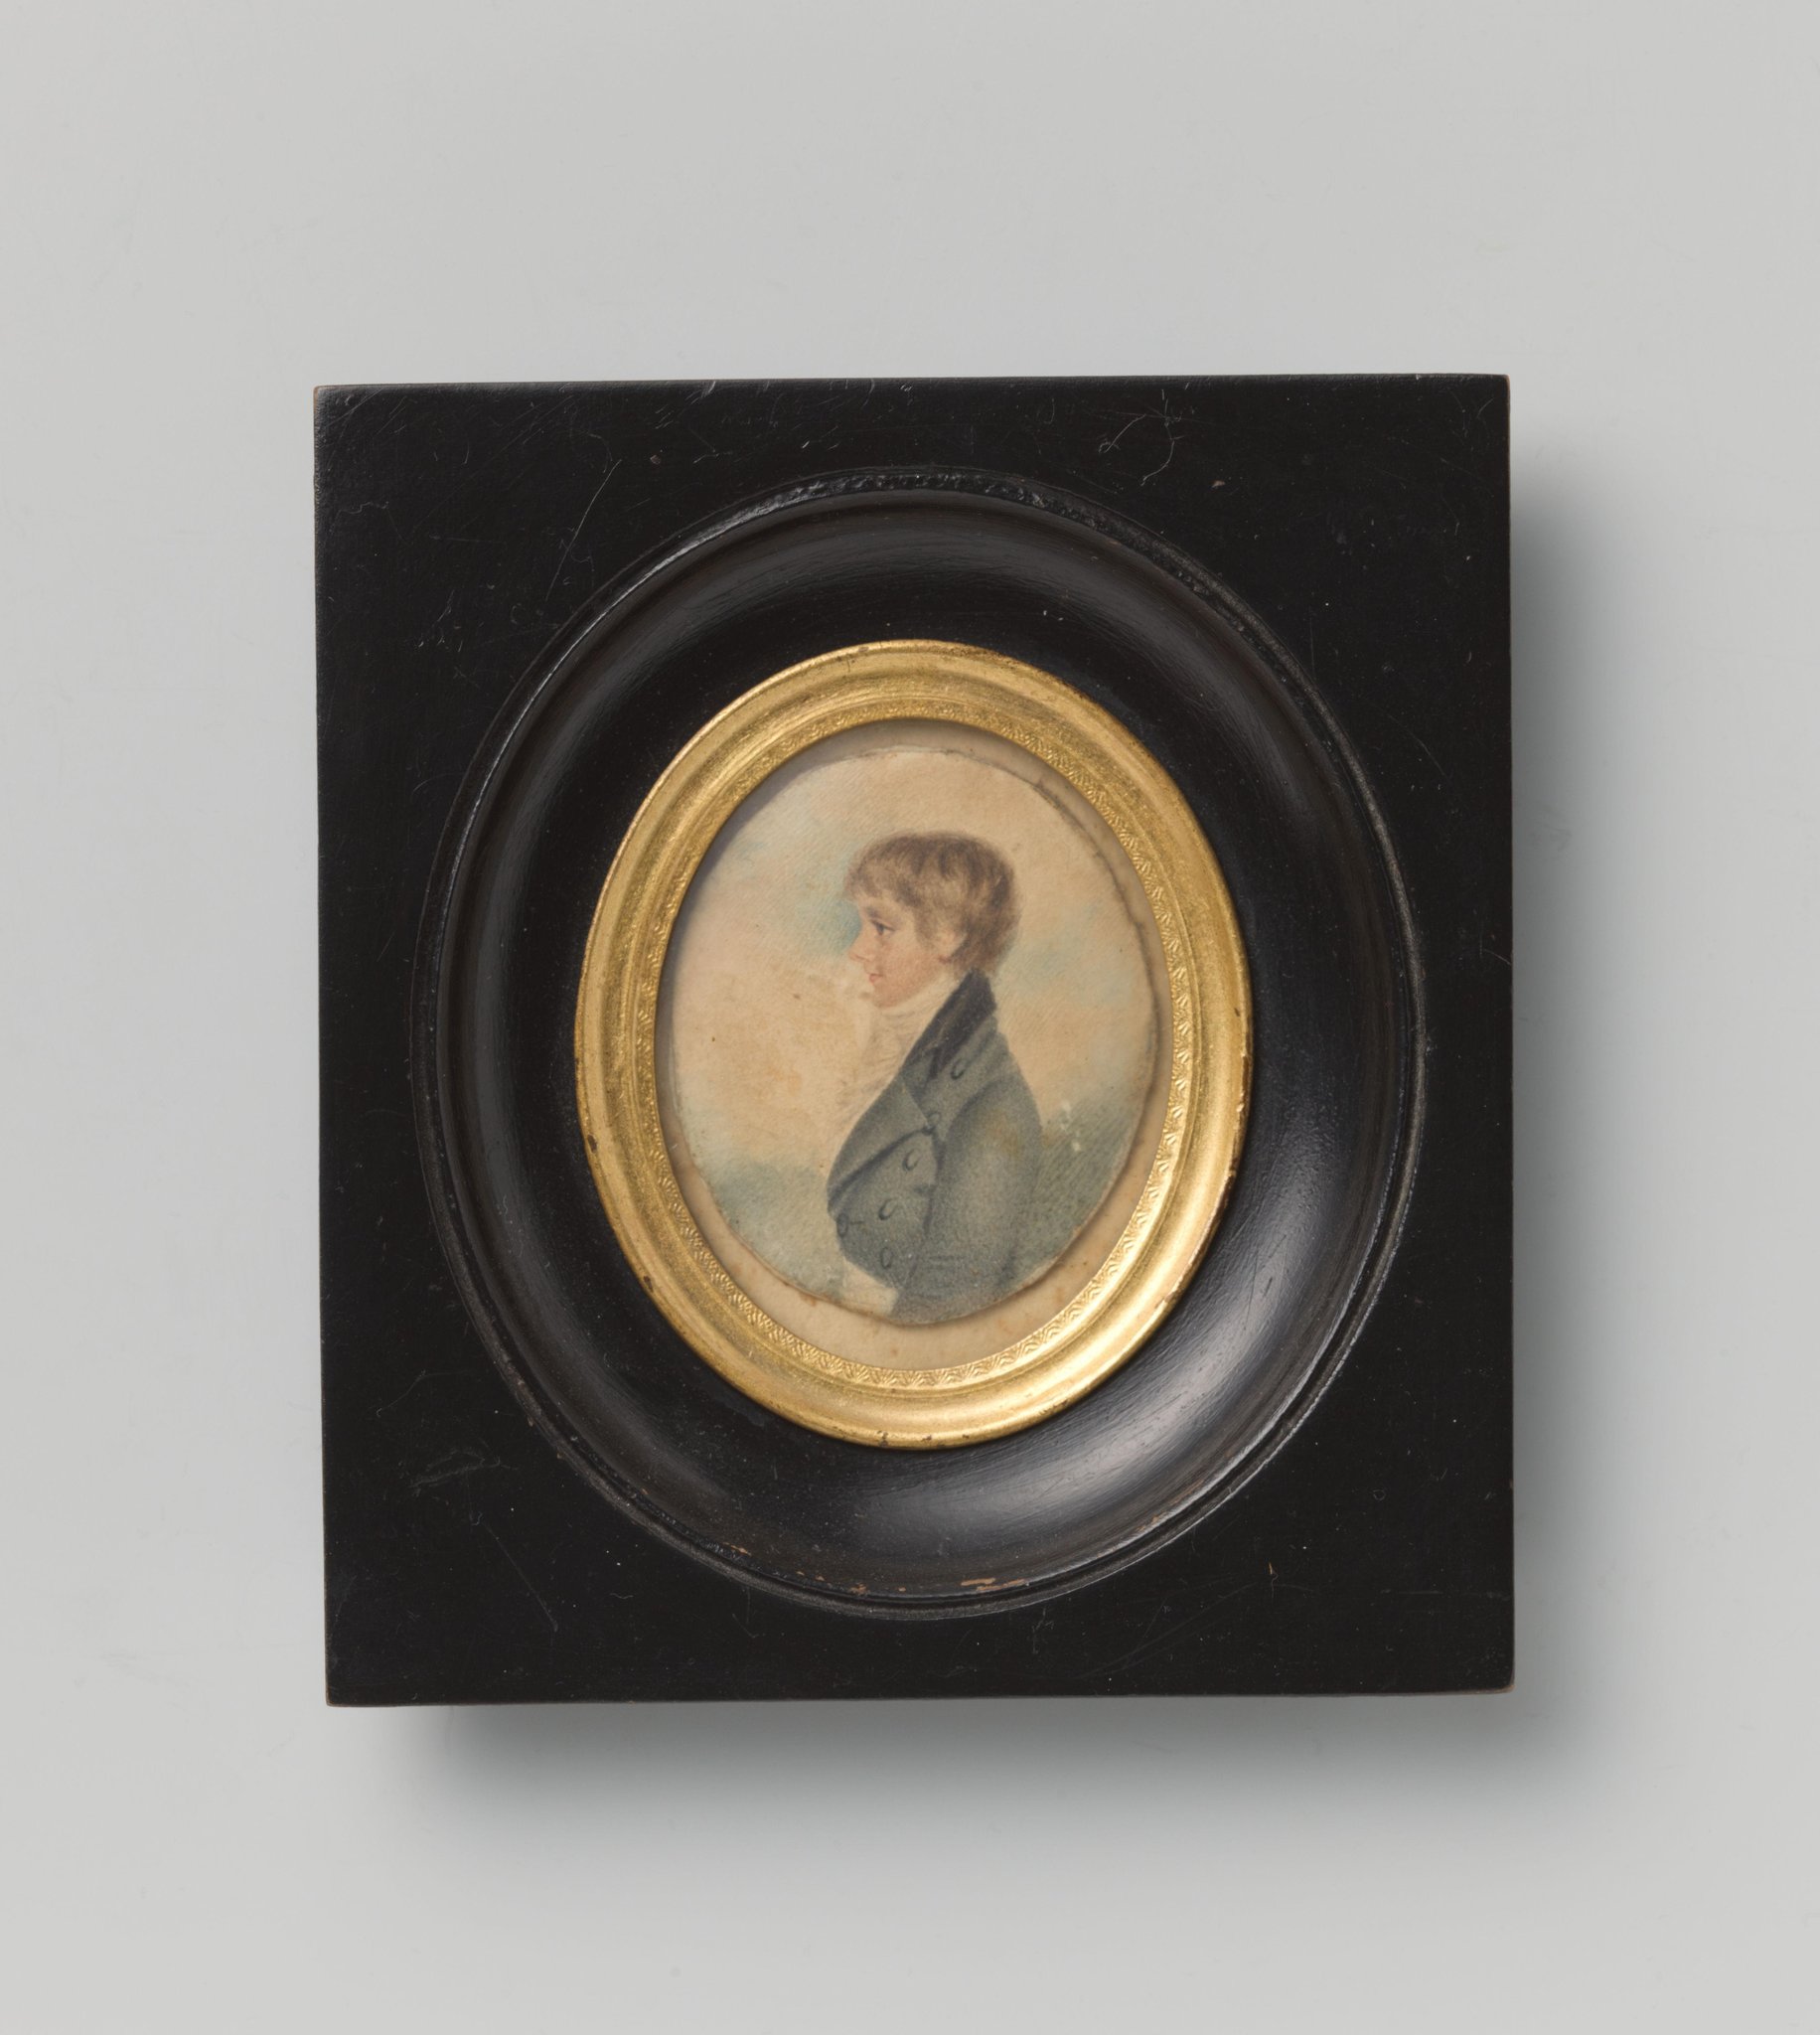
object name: painting, miniature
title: J.W. de Friderici of Jacob François de Friderici (1813/14-1847)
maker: Anonymous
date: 1700-1900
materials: paint, wood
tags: suriname